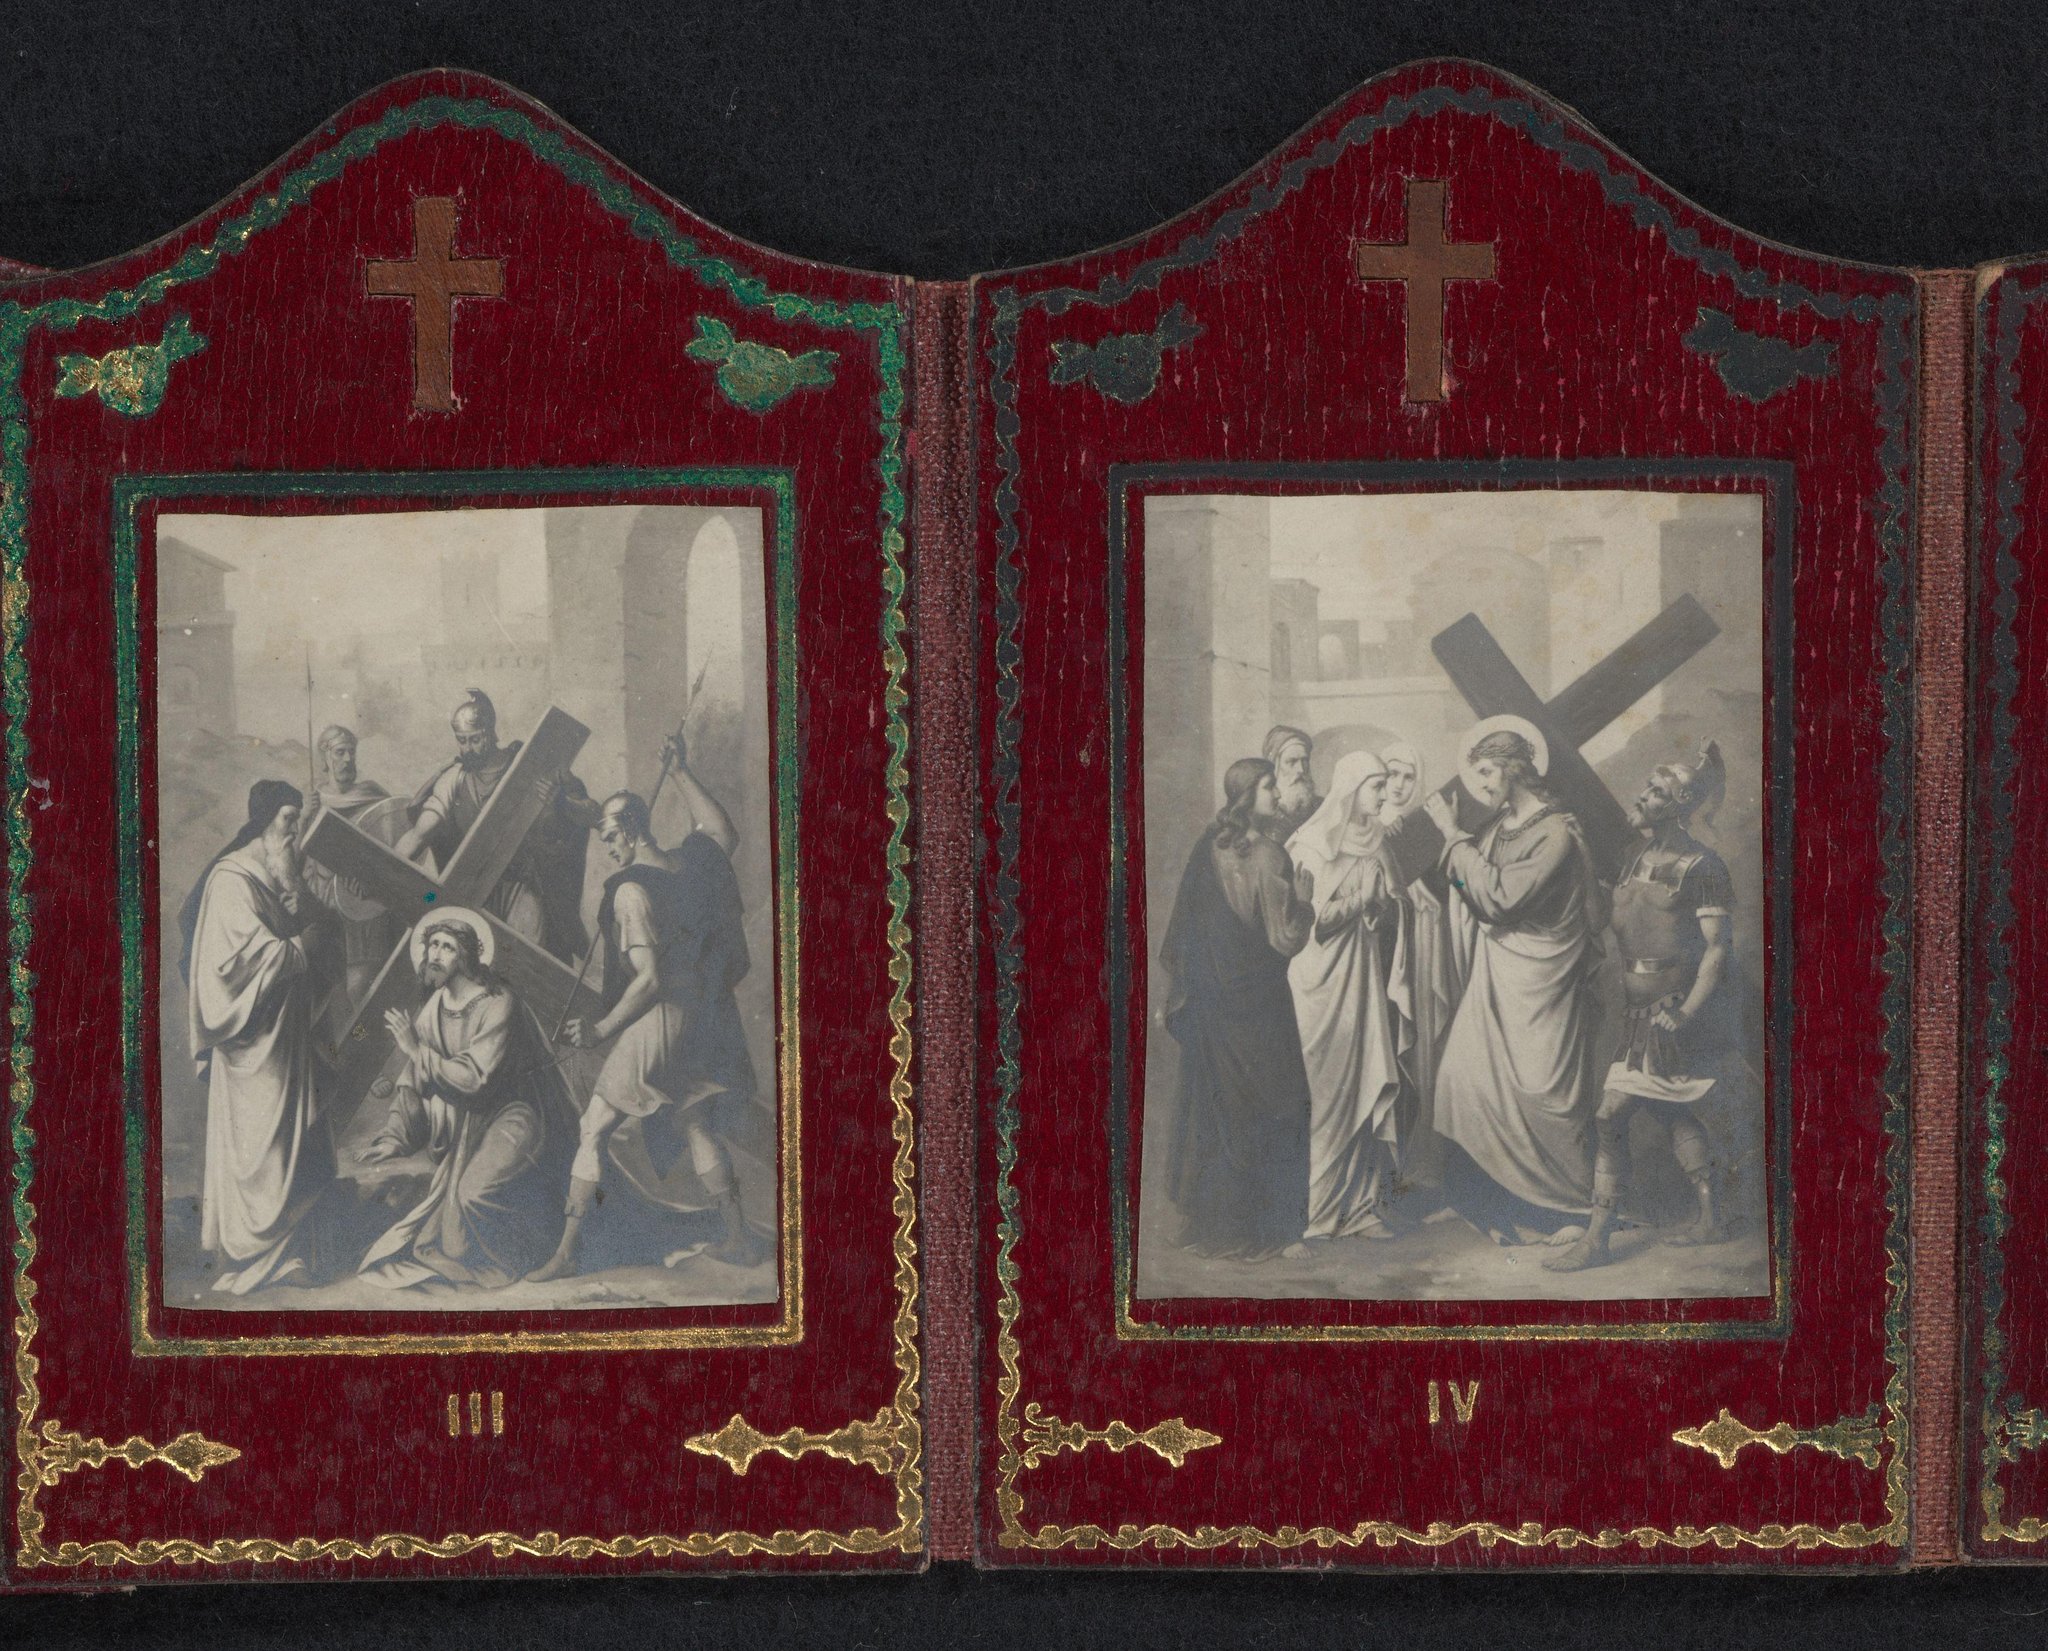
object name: album leaf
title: Fotoreproductie van een schilderij met de vierde kruiswegstatie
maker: Anonymous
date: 1900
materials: paper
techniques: gelatin silver print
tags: stations of the cross, picture, painting